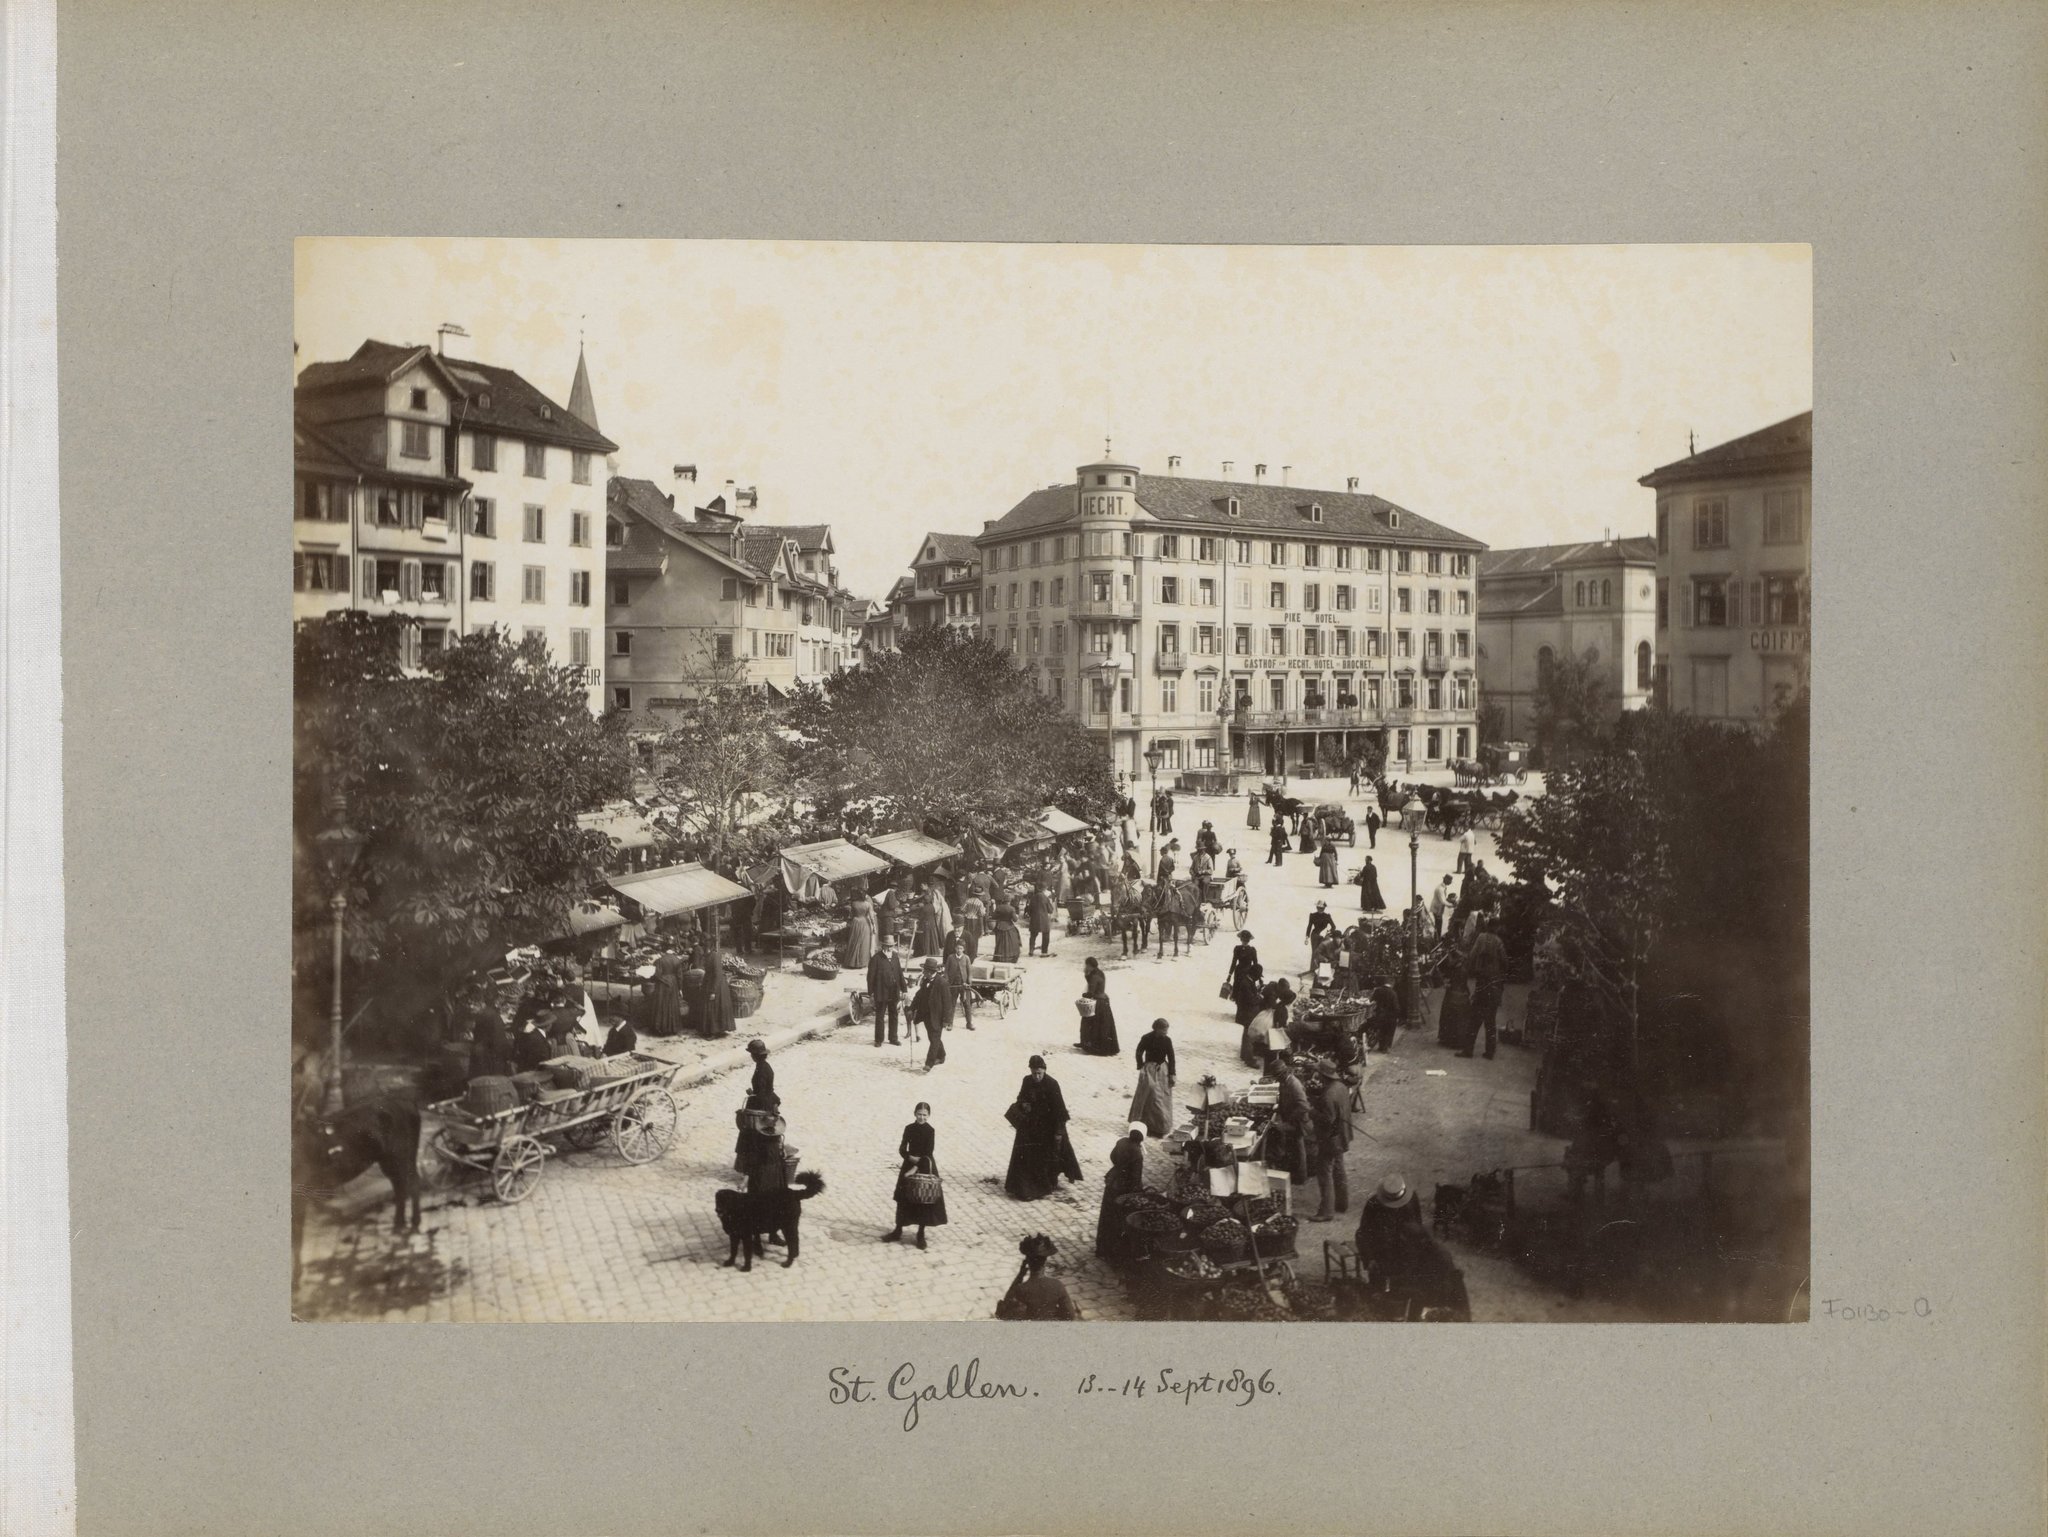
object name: album leaf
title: Straatgezicht met markt in Sankt Gallen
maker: Anonymous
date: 1880-1896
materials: paper, photographic support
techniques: albumen print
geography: sankt gallen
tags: market, street (+ city(-scape) with figures, staffage)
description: Onderdeel van Reisalbum met foto's van bezienswaardigheden in Frankrijk, Spanje, Italië, Duitsland, Zwitserland en Oostenrijk.